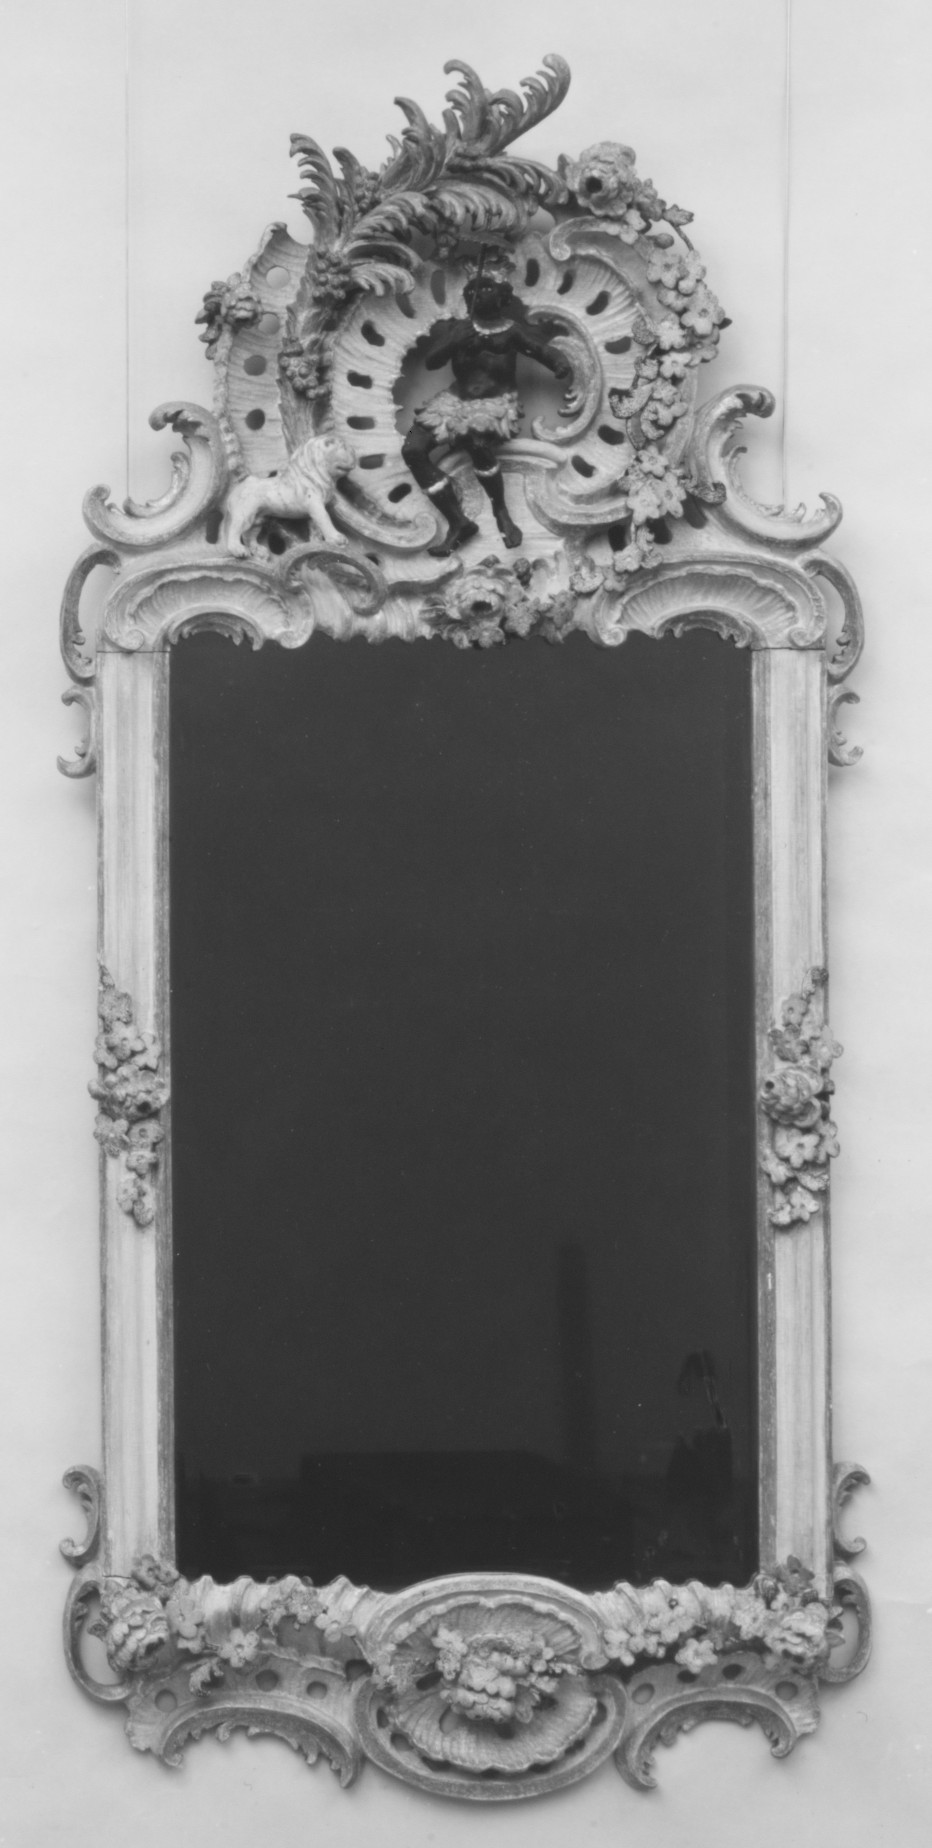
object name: mirror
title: Mirror (one of a pair)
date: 1734-1766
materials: wood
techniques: carving, gilding, painting